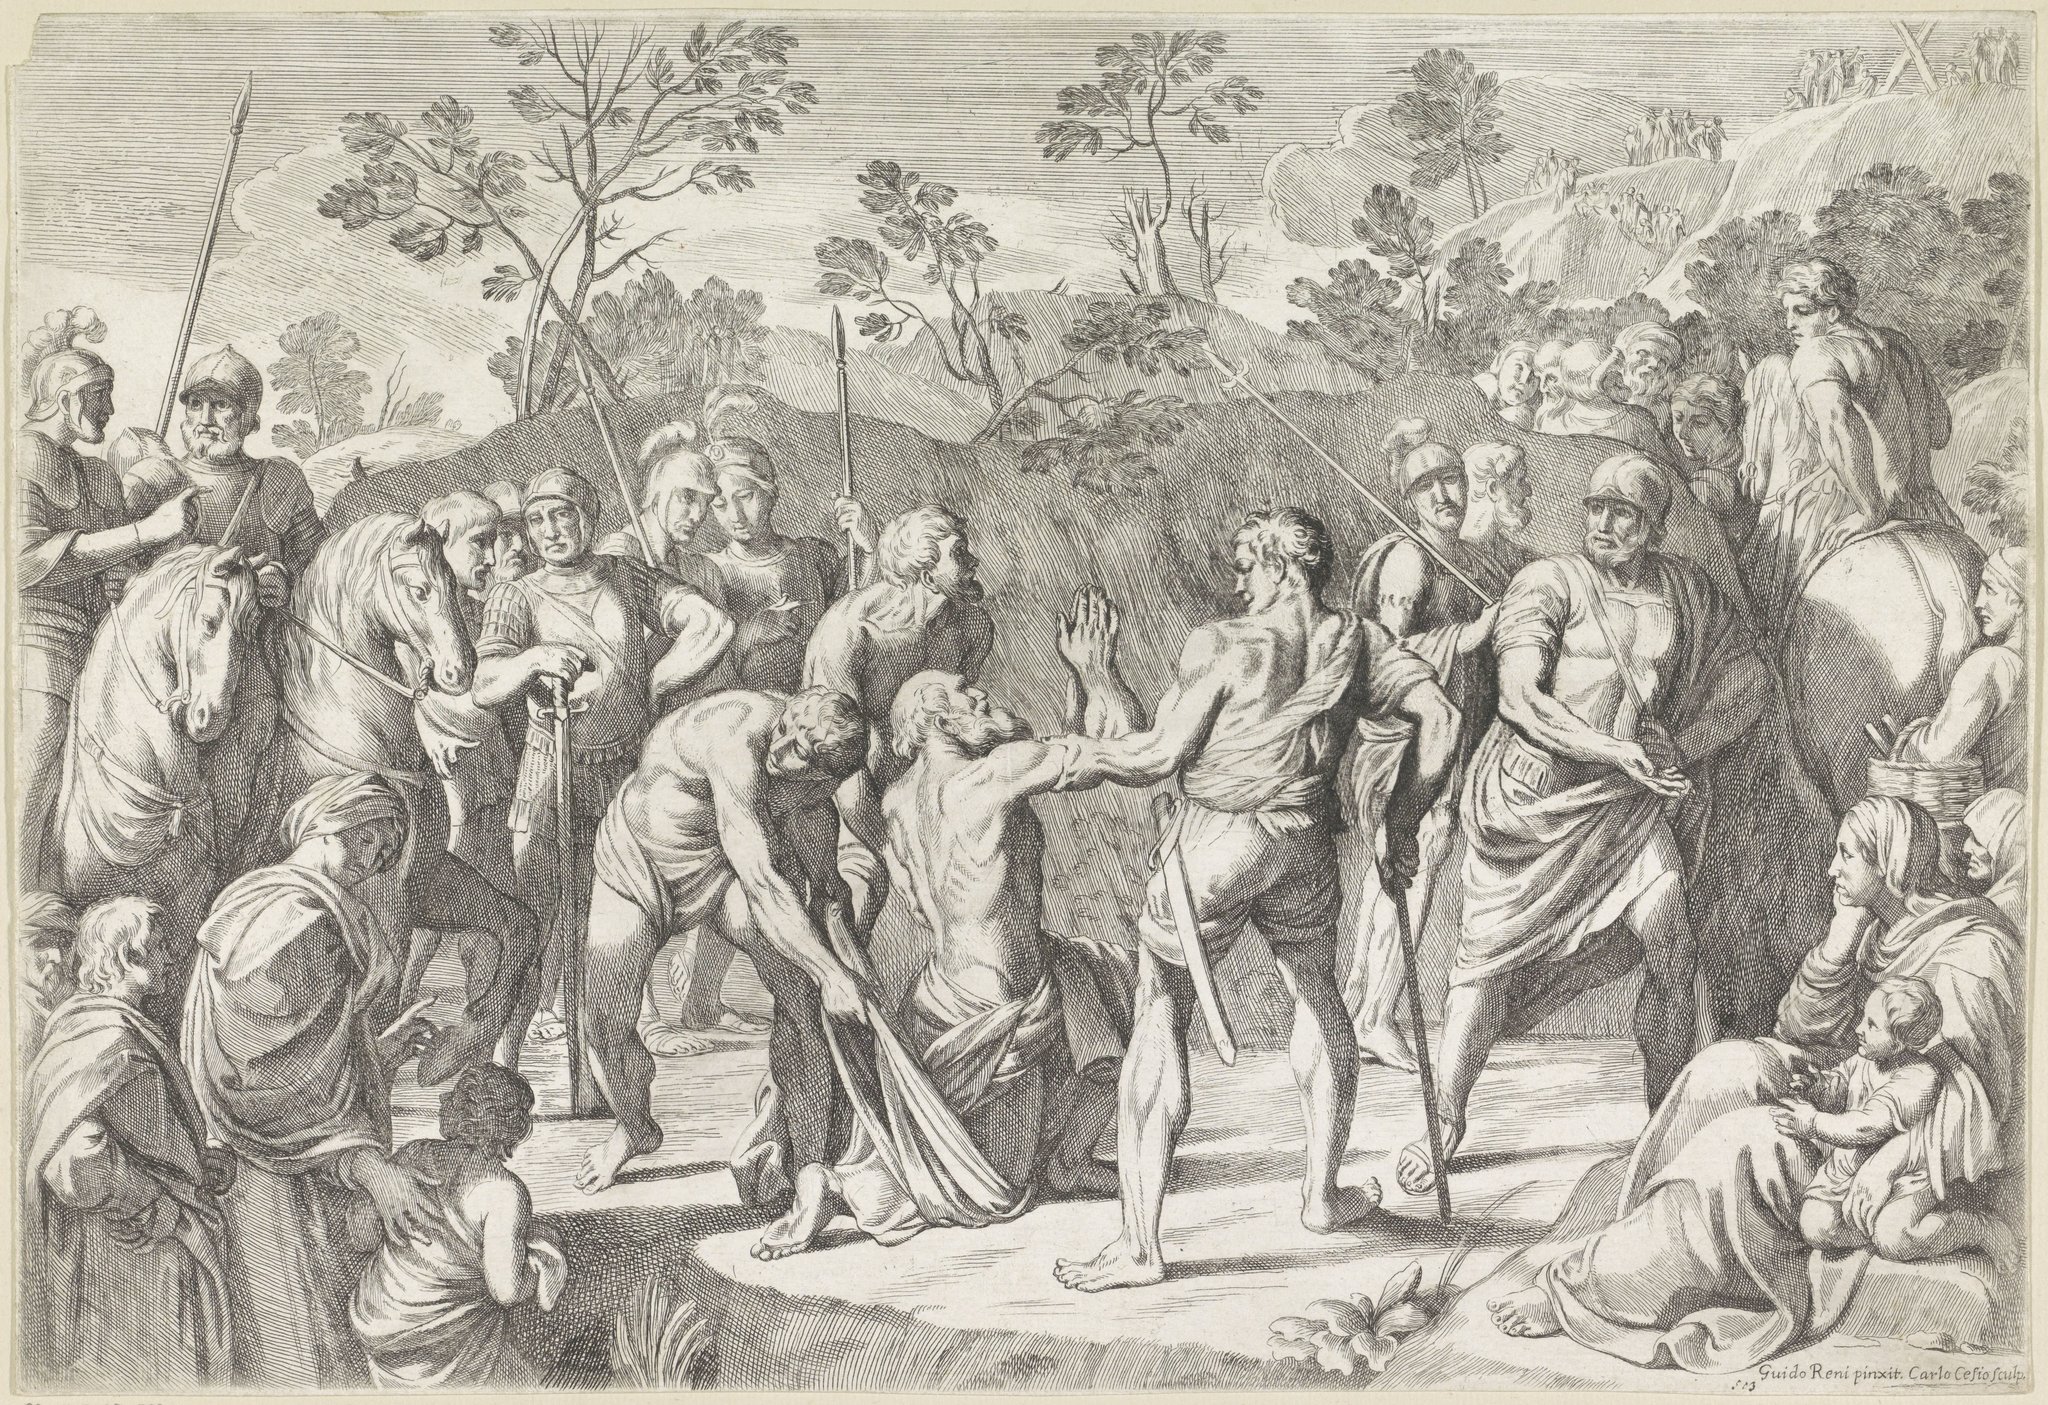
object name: print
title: Martelaarschap van de heilige Andreas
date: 1636-1686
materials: paper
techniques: etching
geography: rome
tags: the apostle andrew; possible attributes: book, x-shaped cross, fish, fishing-net, rope, scroll, andrew on his way to his execution (sometimes led by soldiers)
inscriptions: collector's mark: Lugt 240, number: ‘503’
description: Een stoet van soldaten brengt Andreas naar zijn plek van executie. Bijstanders kijken toe. Andreas knielt op het moment dat hij het kruis ziet waaraan hij gekruisigd zal gaan worden.